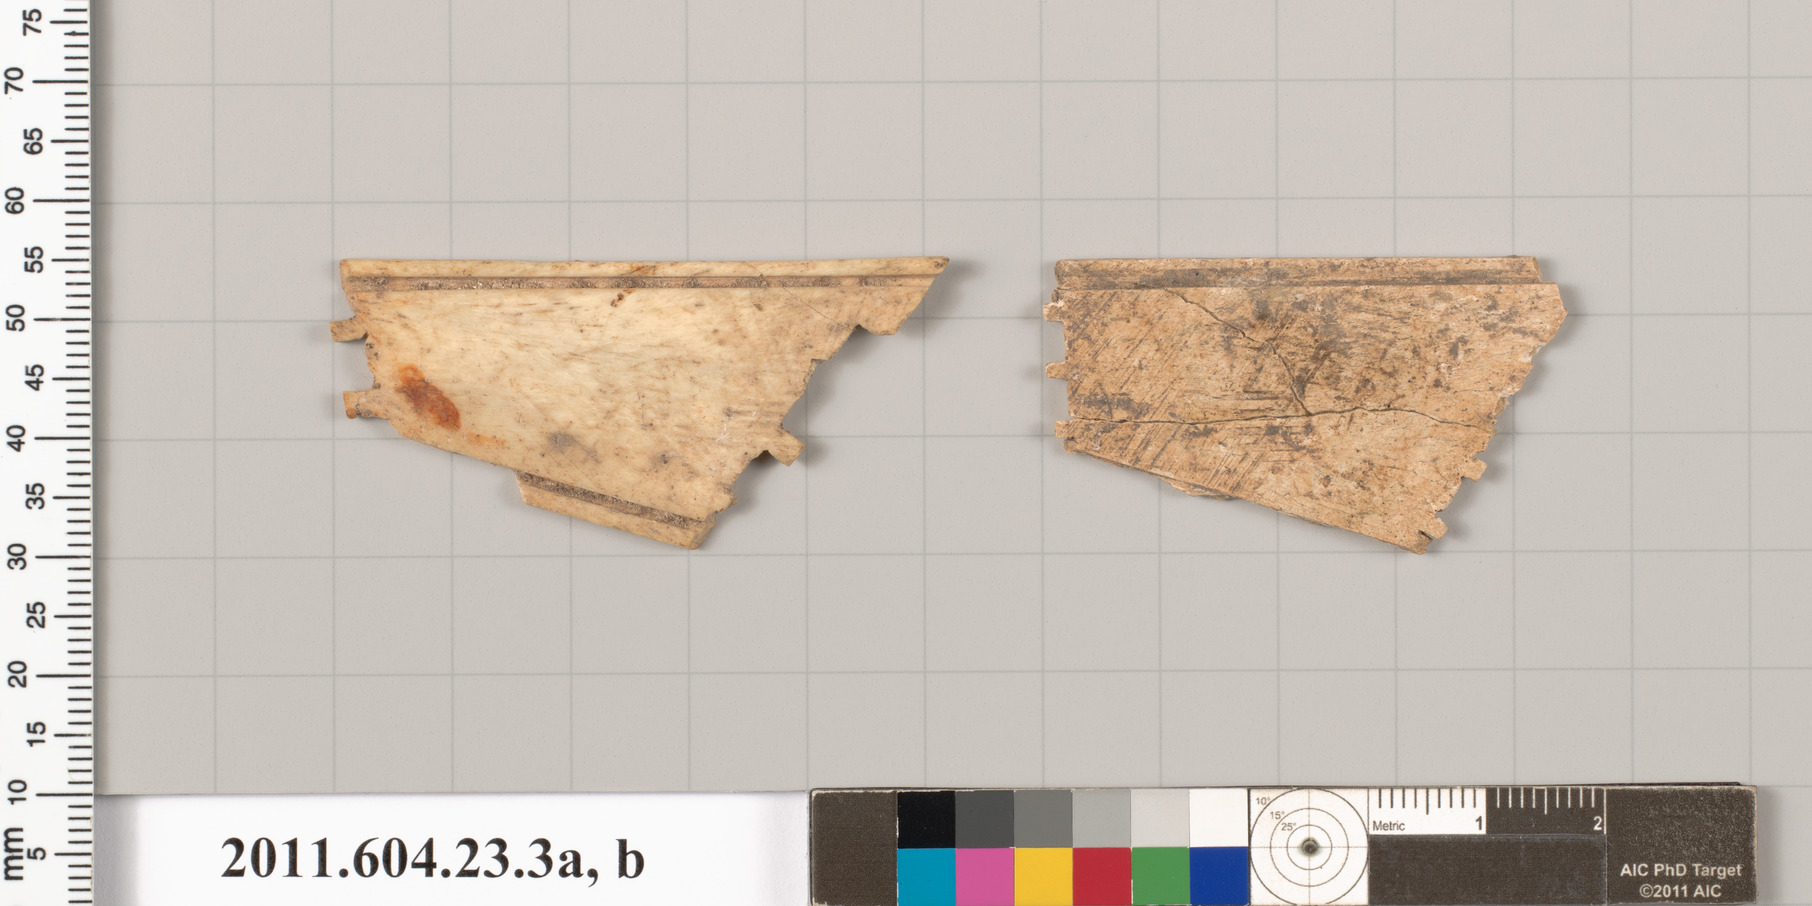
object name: bone or ivory fragment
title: Bone or ivory fragments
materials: bone